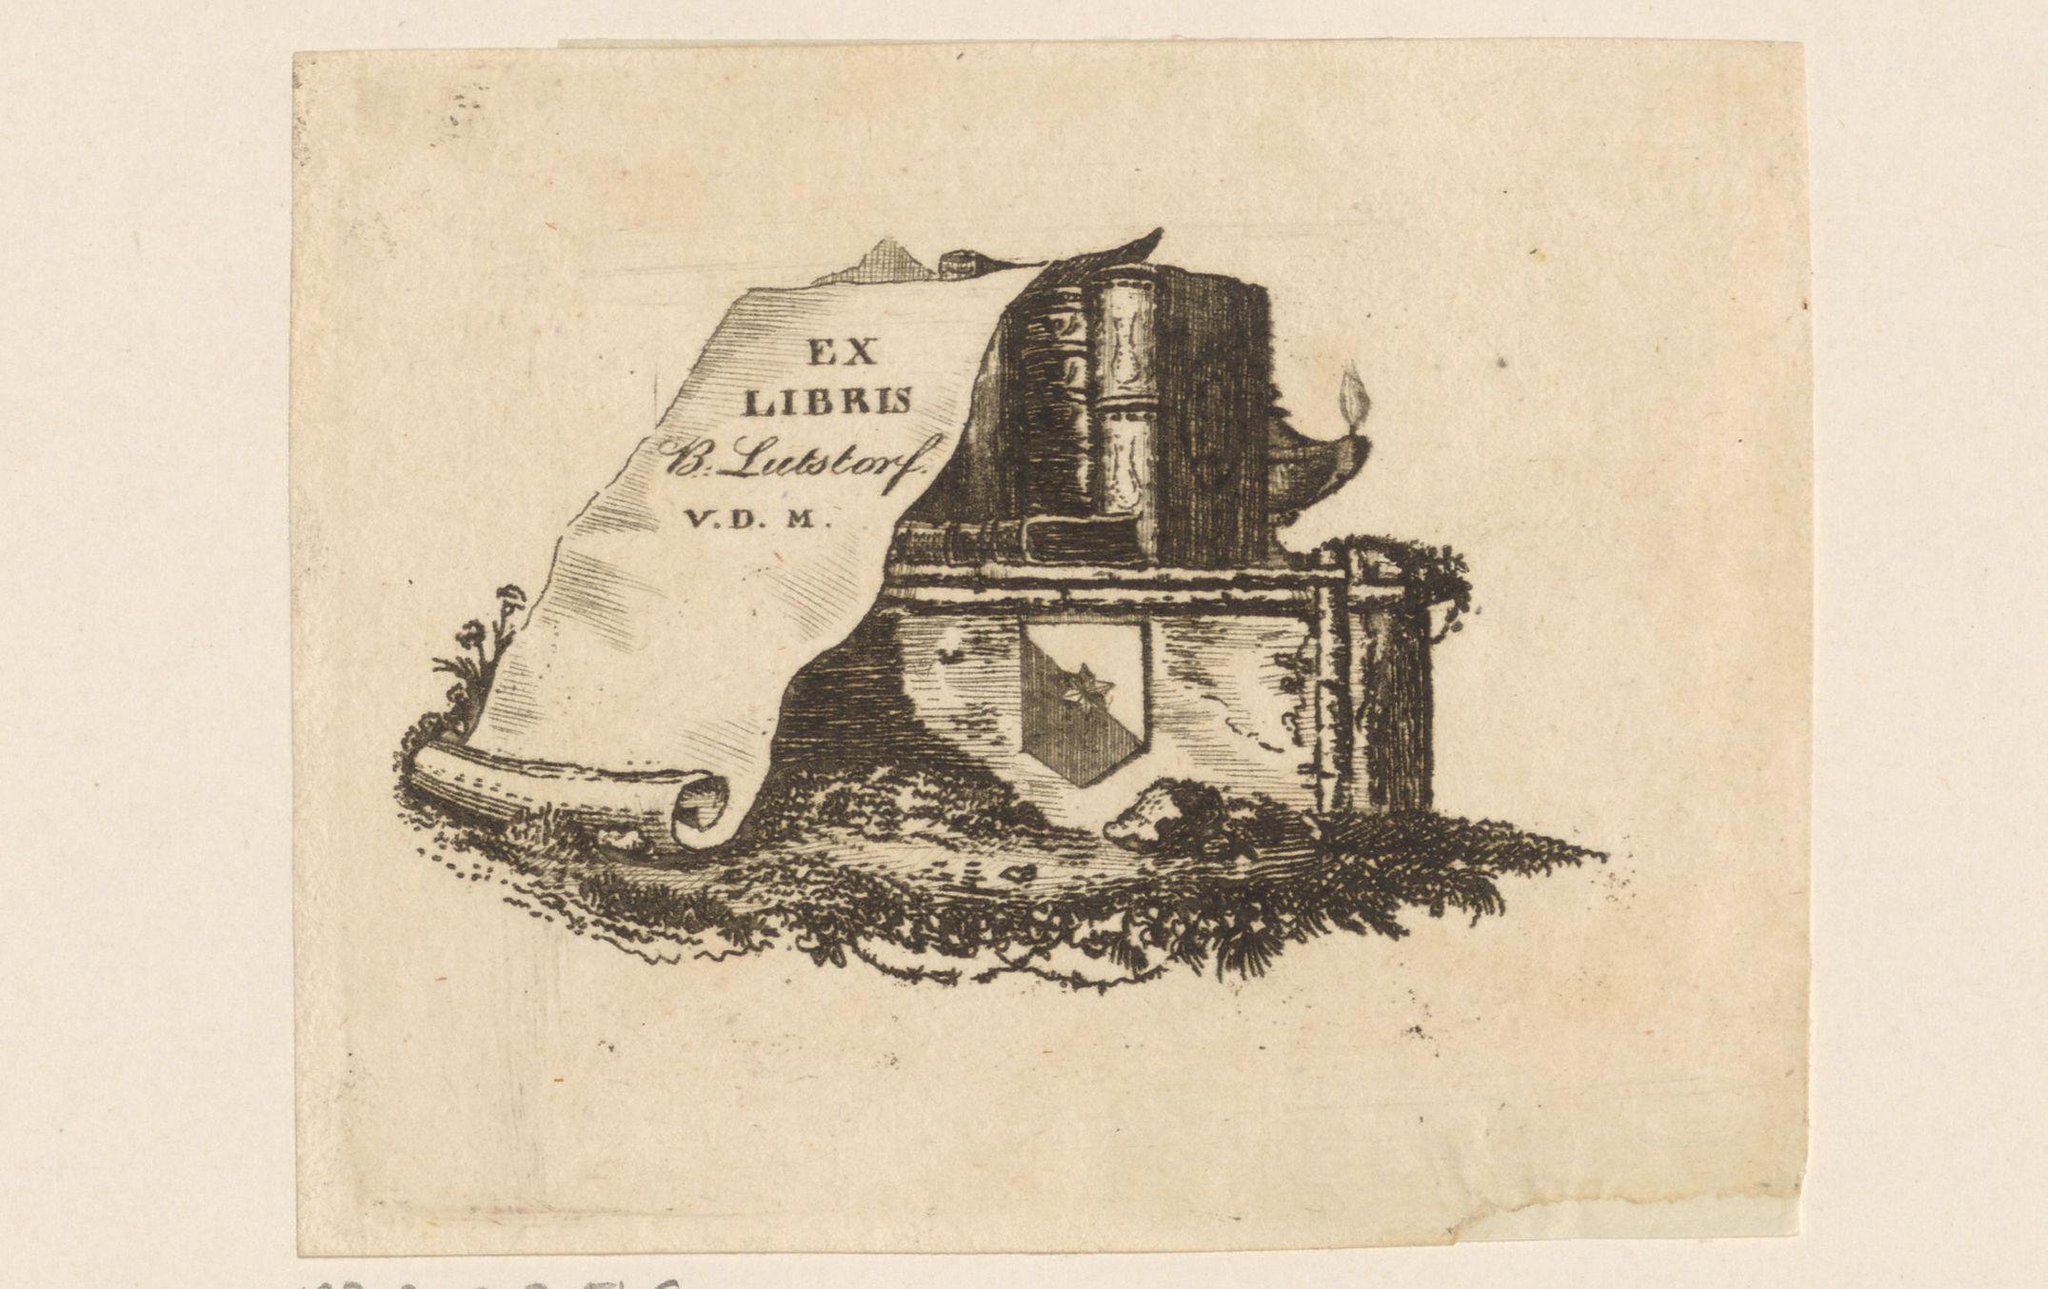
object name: bookplate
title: Ex libris van B. Lutstorf V.D.M.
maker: Anonymous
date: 1750-1849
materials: paper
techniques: etching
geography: germany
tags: scroll - ll - scroll unfolded, column, pillar ~ architecture, armorial bearing, heraldry